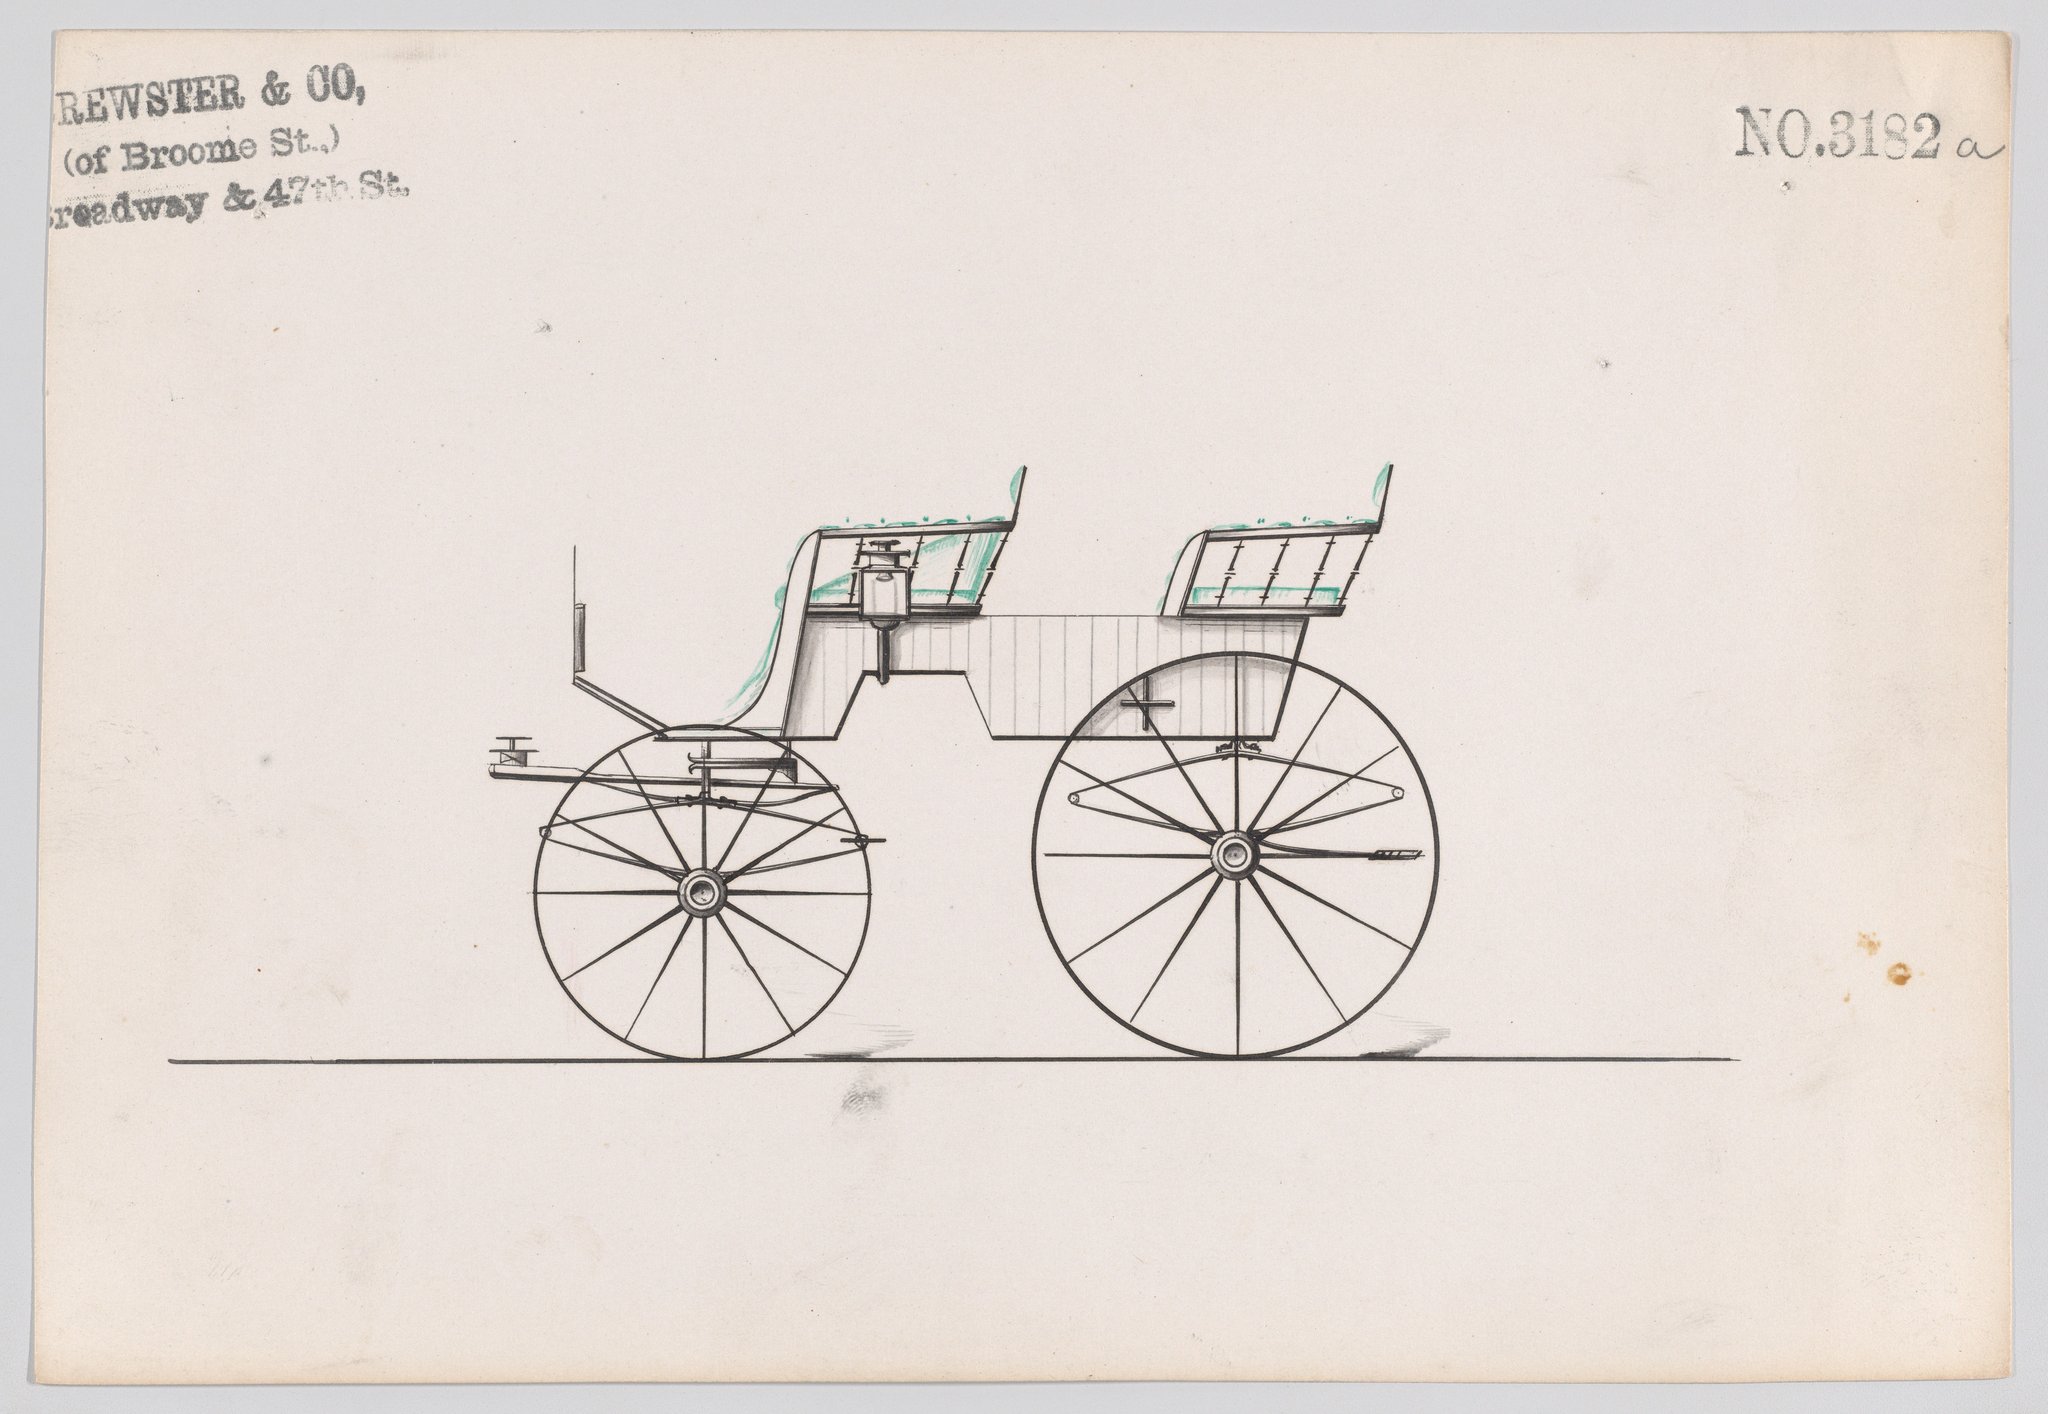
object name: drawing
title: Design for T-Cart, no. 3182a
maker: brewster & co.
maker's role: manufacturer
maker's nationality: american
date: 1876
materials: gouache, ink, watercolor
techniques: pen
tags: carriages